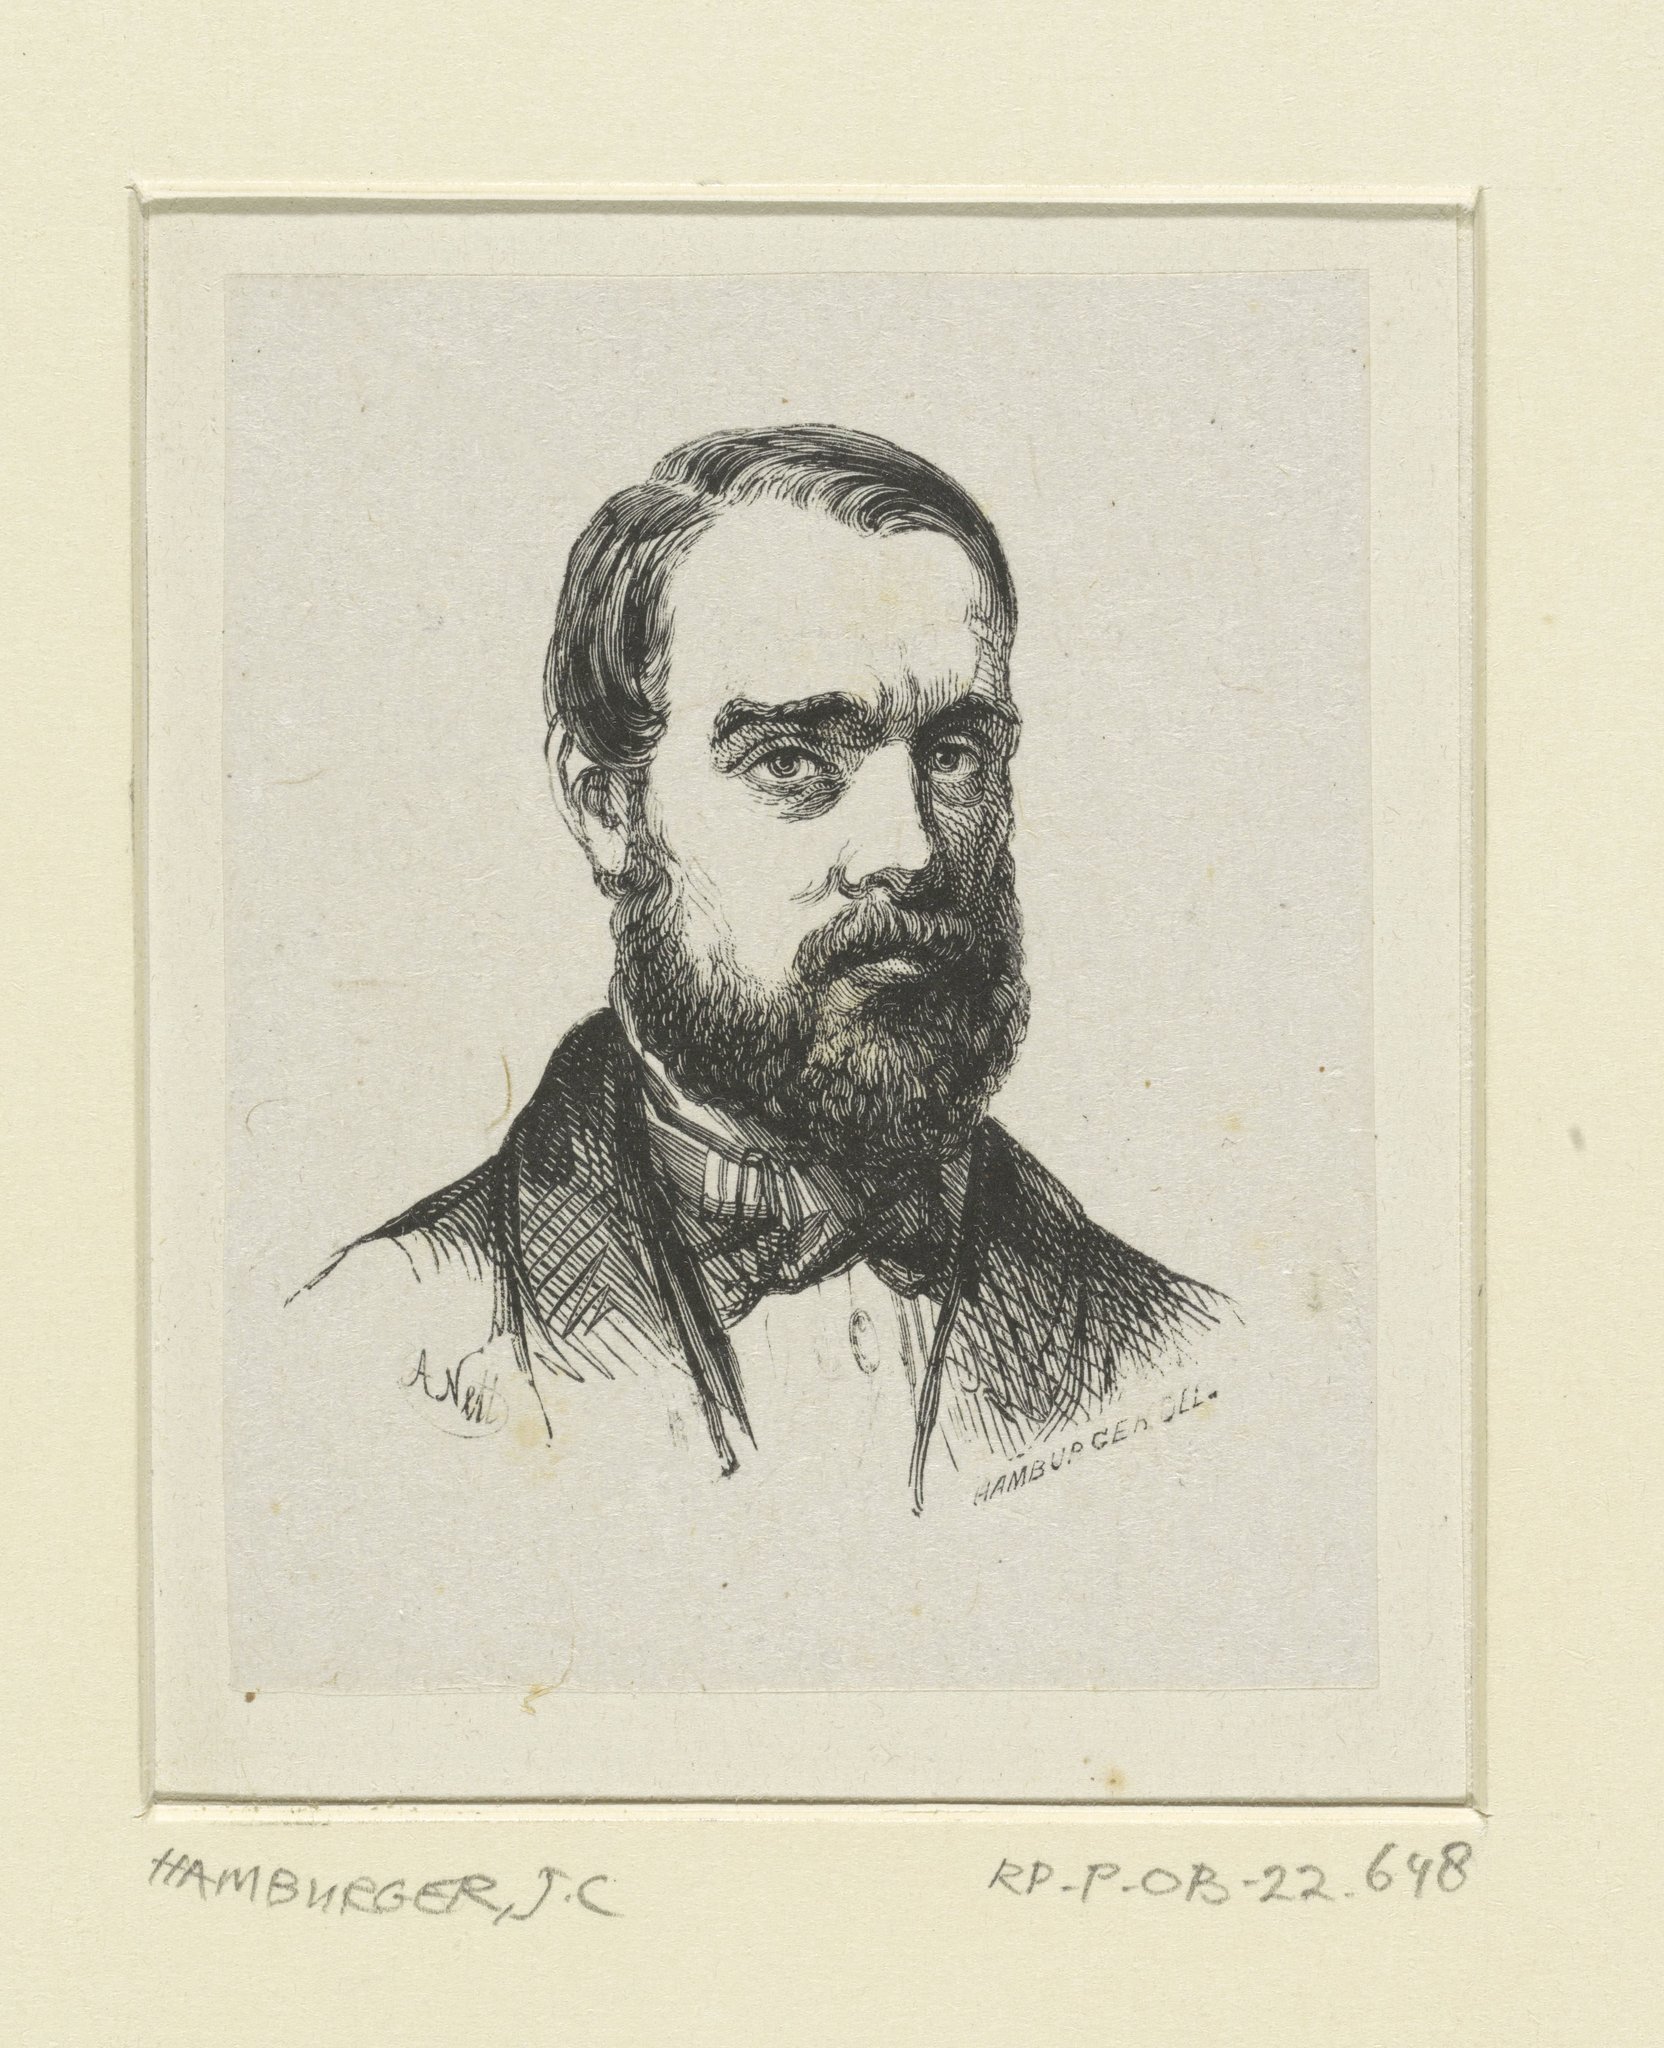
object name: print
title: Portret van Félix De Vigne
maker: coenraad hamburger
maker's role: draughtsman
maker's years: 1809-1891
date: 1819-1876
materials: paper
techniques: engraving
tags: ghent, draughtsman, félix de vigne, historical persons, portrait, self-portrait of painter, portrait, self-portrait of artist, portrait, self-portrait of draughtsman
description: Portret van de schilder en tekenaar Félix de Vigne.